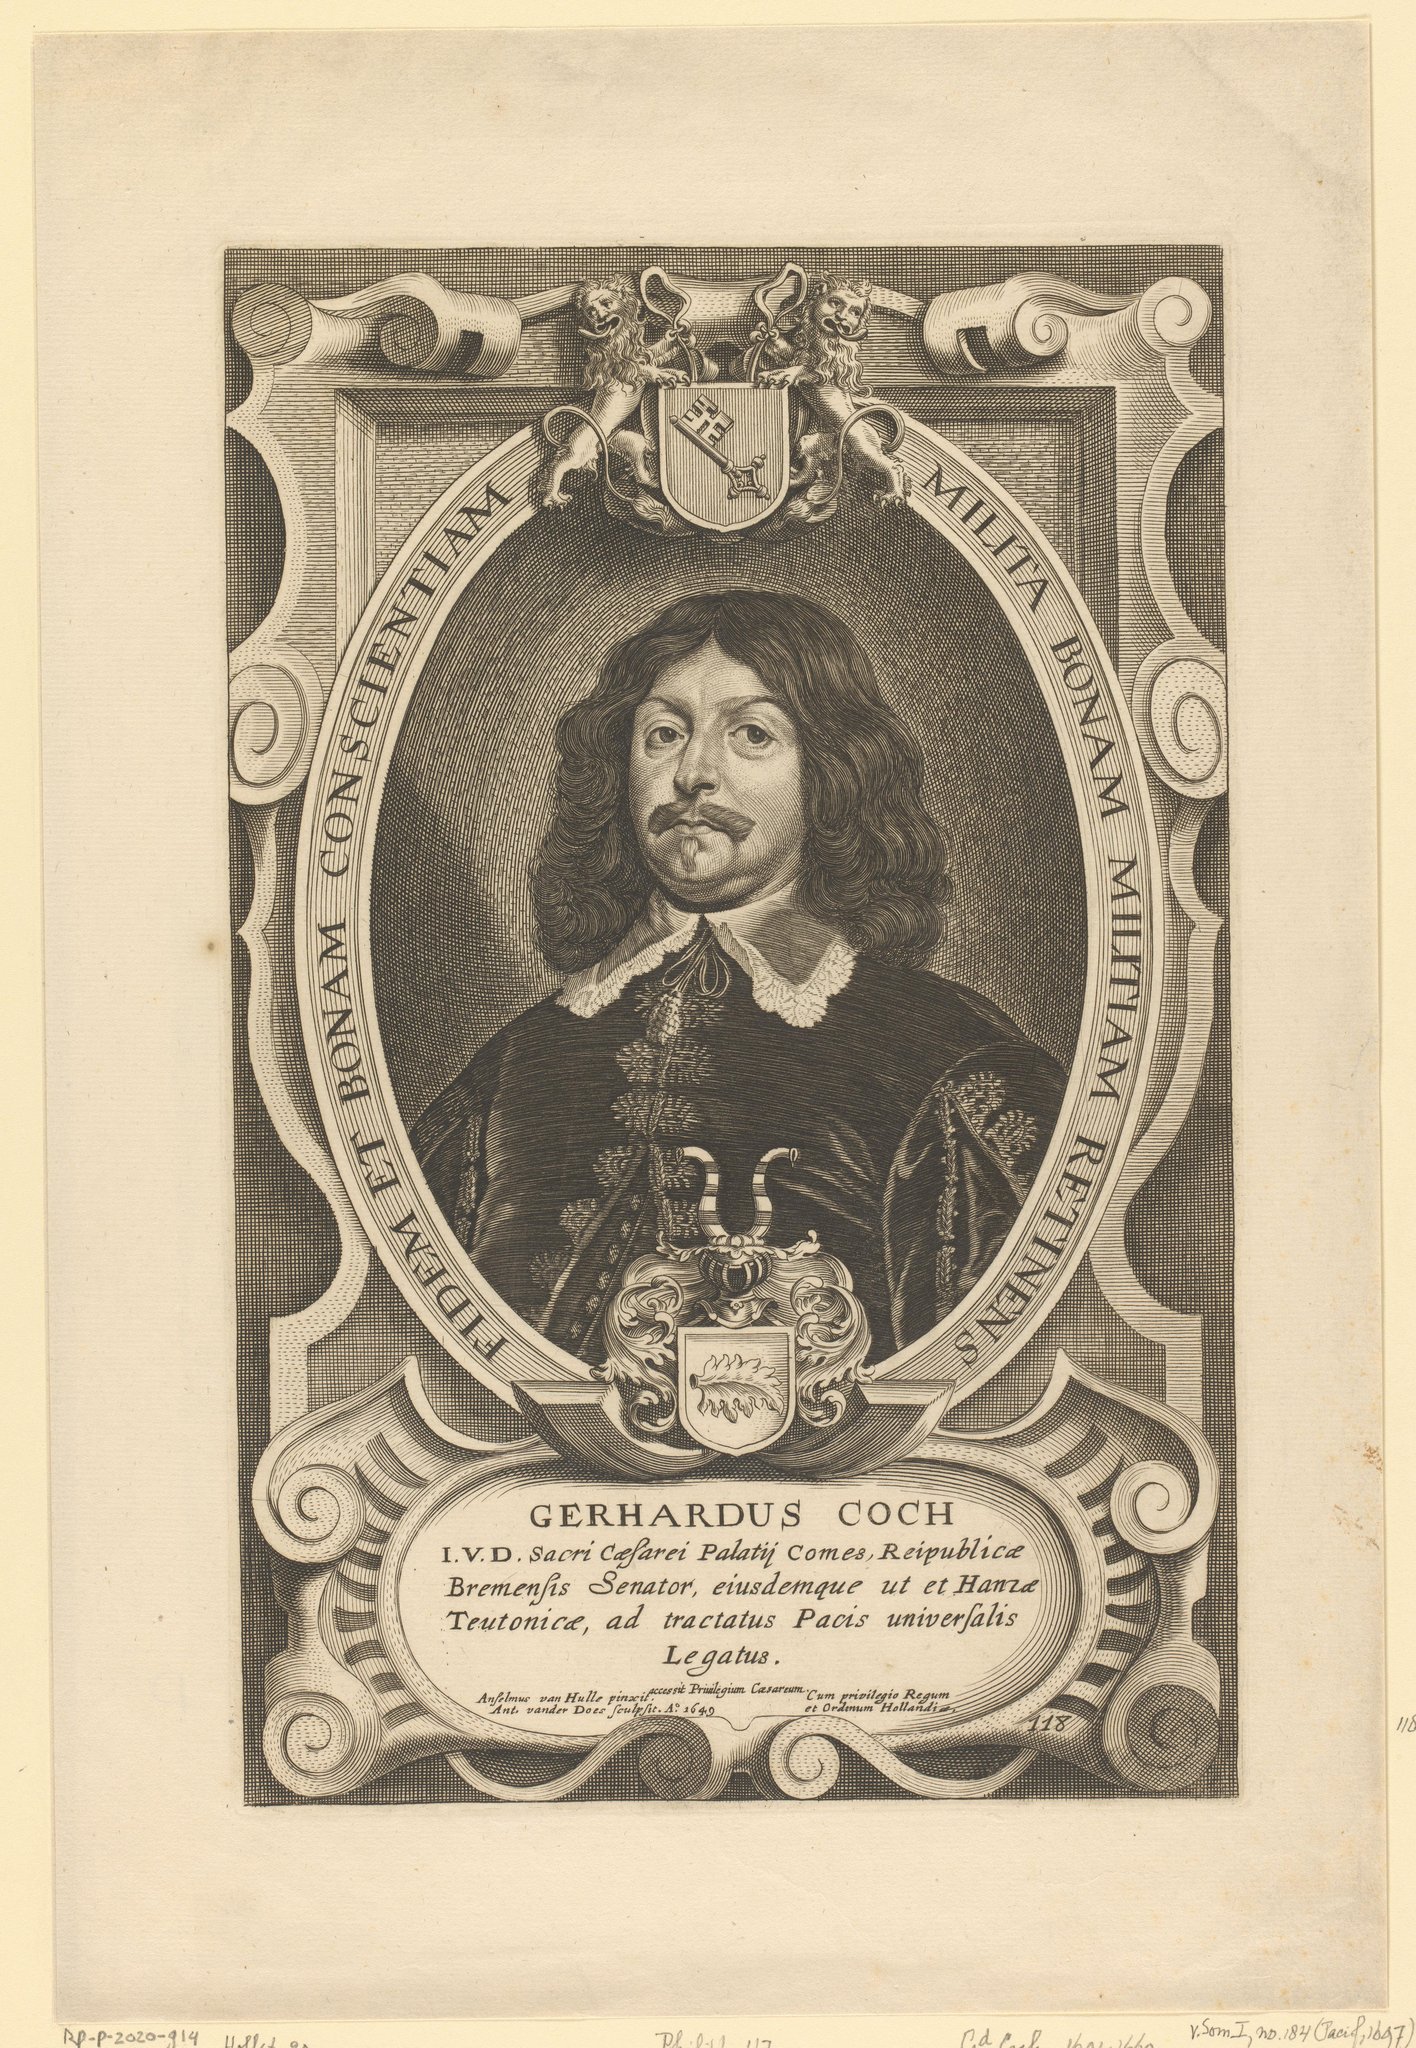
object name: print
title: Gerhardus Coch I.U.D. sacri caesarei Palatij comes, reipublicae Bremensis senator (...)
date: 1713-1717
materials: paper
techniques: engraving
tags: historical persons, lawyer, attorney at law, diplomacy, diplomat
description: Prent is gebruikt in verschillende series. De huidige staat is gebruikt in de hieronder vermelde serie en uitgaven (6) en (7). (1)‘Legati Celeberrimi’, uitgegeven door Daniel Middeler in 1648 in Antwerpen. (2)‘Legati Celeberrimi’, waarschijnlijk uitgegeven in 1651, maar opnieuw met de vermelding door Daniel Middeler in 1648 in Antwerpen. (3)‘Legati Celeberrimi', waarschijnlijk uitgegeven in 1658, maar opnieuw met de vermelding door Daniel Middeler in 1648 in Antwerpen. (4) 'Pacificatores orbis Christiani, sive icones principum, ducum et legatorum, qui Monasterii atque Osnabrugae (...)', uitgegeven door Pieter van der Slaart in 1696 in Rotterdam. (5) 'Pacificatores orbis Christiani, sive icones principum, ducum et legatorum, qui Monasterii atque Osnabrugae (...)', uitgegeven door Pieter van der Slaart in 1697 in Rotterdam. (6) 'Pacificatores orbis Christiani, sive icones principum, ducum et legatorum, qui Monasterii atque Osnabrugae (...)', waarschijnlijk uitgegeven circa 1713, maar opnieuw met vermelding van Pieter van der Slaart in 1697 in Rotterdam. De platen in deze uitgave zijn voor het eerst genummerd. (7) 'Les hommes illustres qui ont vécu dans le XXIIe siècle (...)', uitgegeven door David Mortier in 1717 in Rotterdam. Zie documentatie. Mogelijk zijn er nog meerdere uitgaven en staten van deze prent.